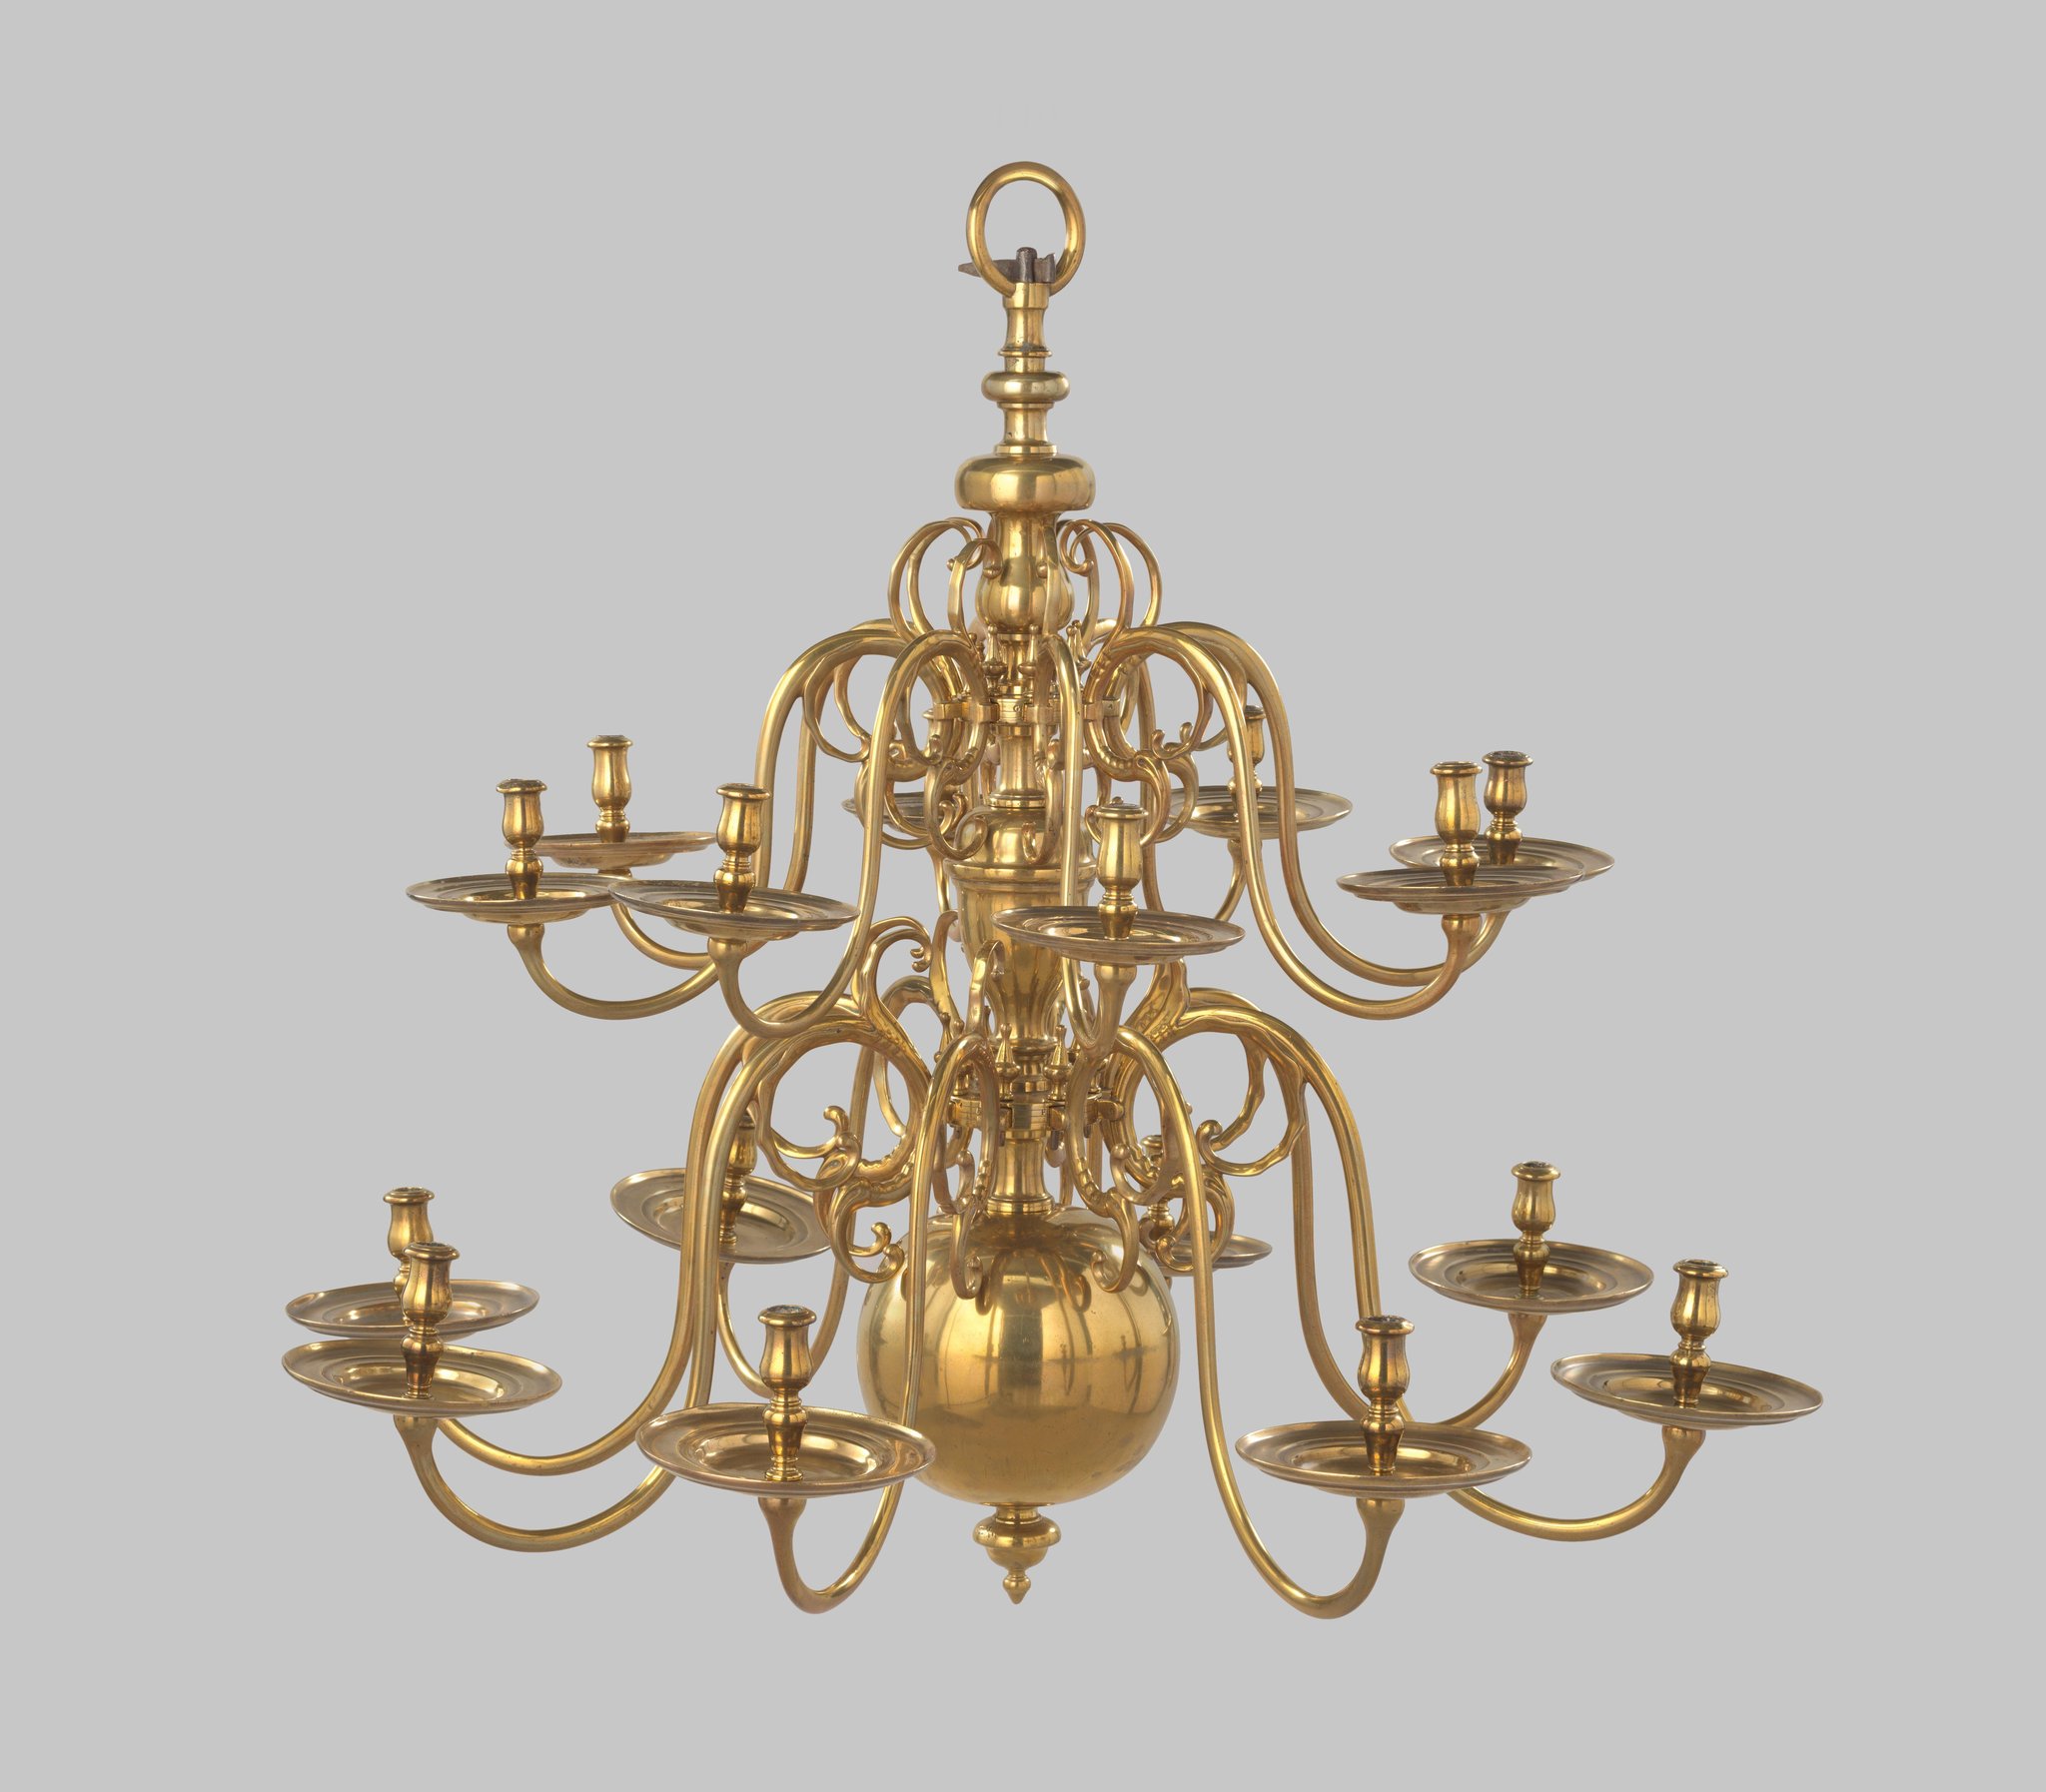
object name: chandelier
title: Stam van een kaarsenkroon in twee hoogten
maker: Anonymous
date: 1650-1675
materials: brass, iron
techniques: casting, forging, turning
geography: amsterdam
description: Het voorwerp bestaat uit een ronde smeedijzeren stang, een ijzeren splitpen en de volgende gegoten en daarna op de draaibank bewerkte delen: de hangring, het stamdeel met de bovenste standring, het stamdeel met de onderste standring, de bol en de knop. De ronde hangring gaat onderaan over in een geprofileerde bolle cylinder. Het stamdeel met de bovenste standring is aldaar bij de armsgaten A t/m H gemerkt en met doorgaans telkens telkens twee gegroefde ringen versierd. Boven de standring heeft dit onderdeel de vorm van een paddenstoel tussen twee holrond geprofileerde delen. Het stuk onder de standring is ook holrond geprofileerd. Het stamdeel met de onderste standring is aldaar bij de armsgaten eveneens A t/m H gemerkt en met gegroefde ringen versierd. Boven deze standring heeft het de vorm van een geprofileerde zich naar onder verjongende baluster, daaronder heeft het een bolronde contour. De bol is aan onder- en bovenkant voorzien van een gat. De krachtig geprofileerde knop, die in een peervormig knopje eindigt, is aan de smeedijzeren stang bevestigd.